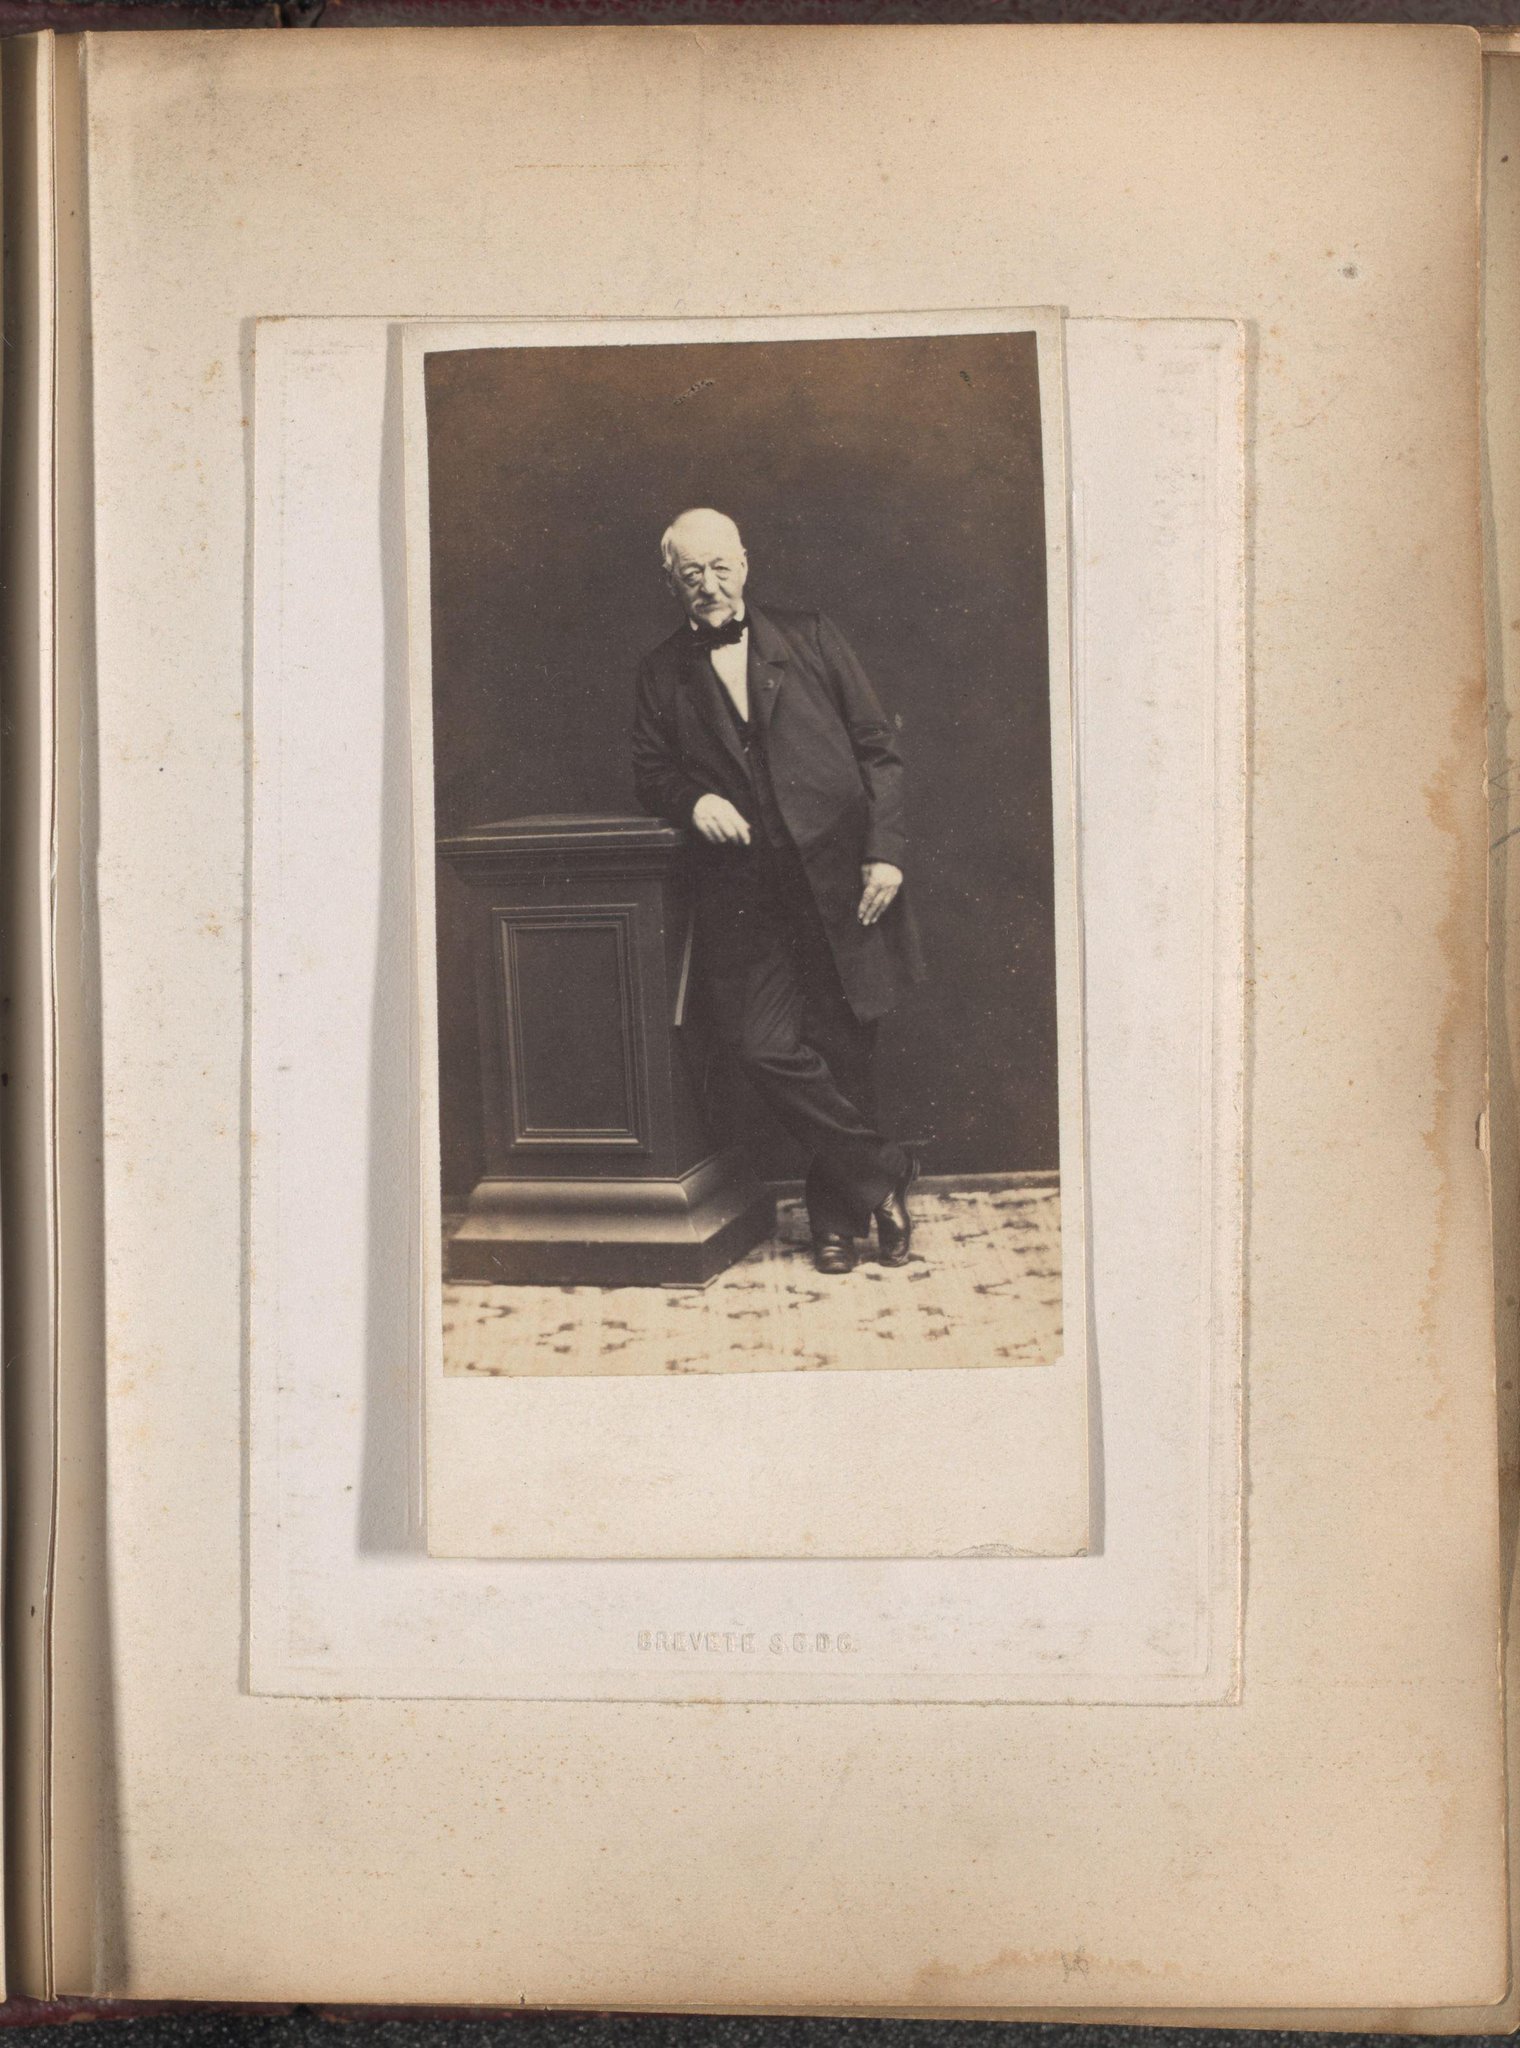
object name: carte de visite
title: Portret van een man met een sikje in een lange jas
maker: Anonymous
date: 1860-1865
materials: cardboard, paper, photographic support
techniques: albumen print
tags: trousers, breeches, historical persons, styles of hairdress - aa - ~ women, neck-gear ~ clothing, beard, coat, cape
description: Onderdeel van Fotoalbum met 48 cartes-de-visite aangeboden aan maarschalk graaf De Castellane.